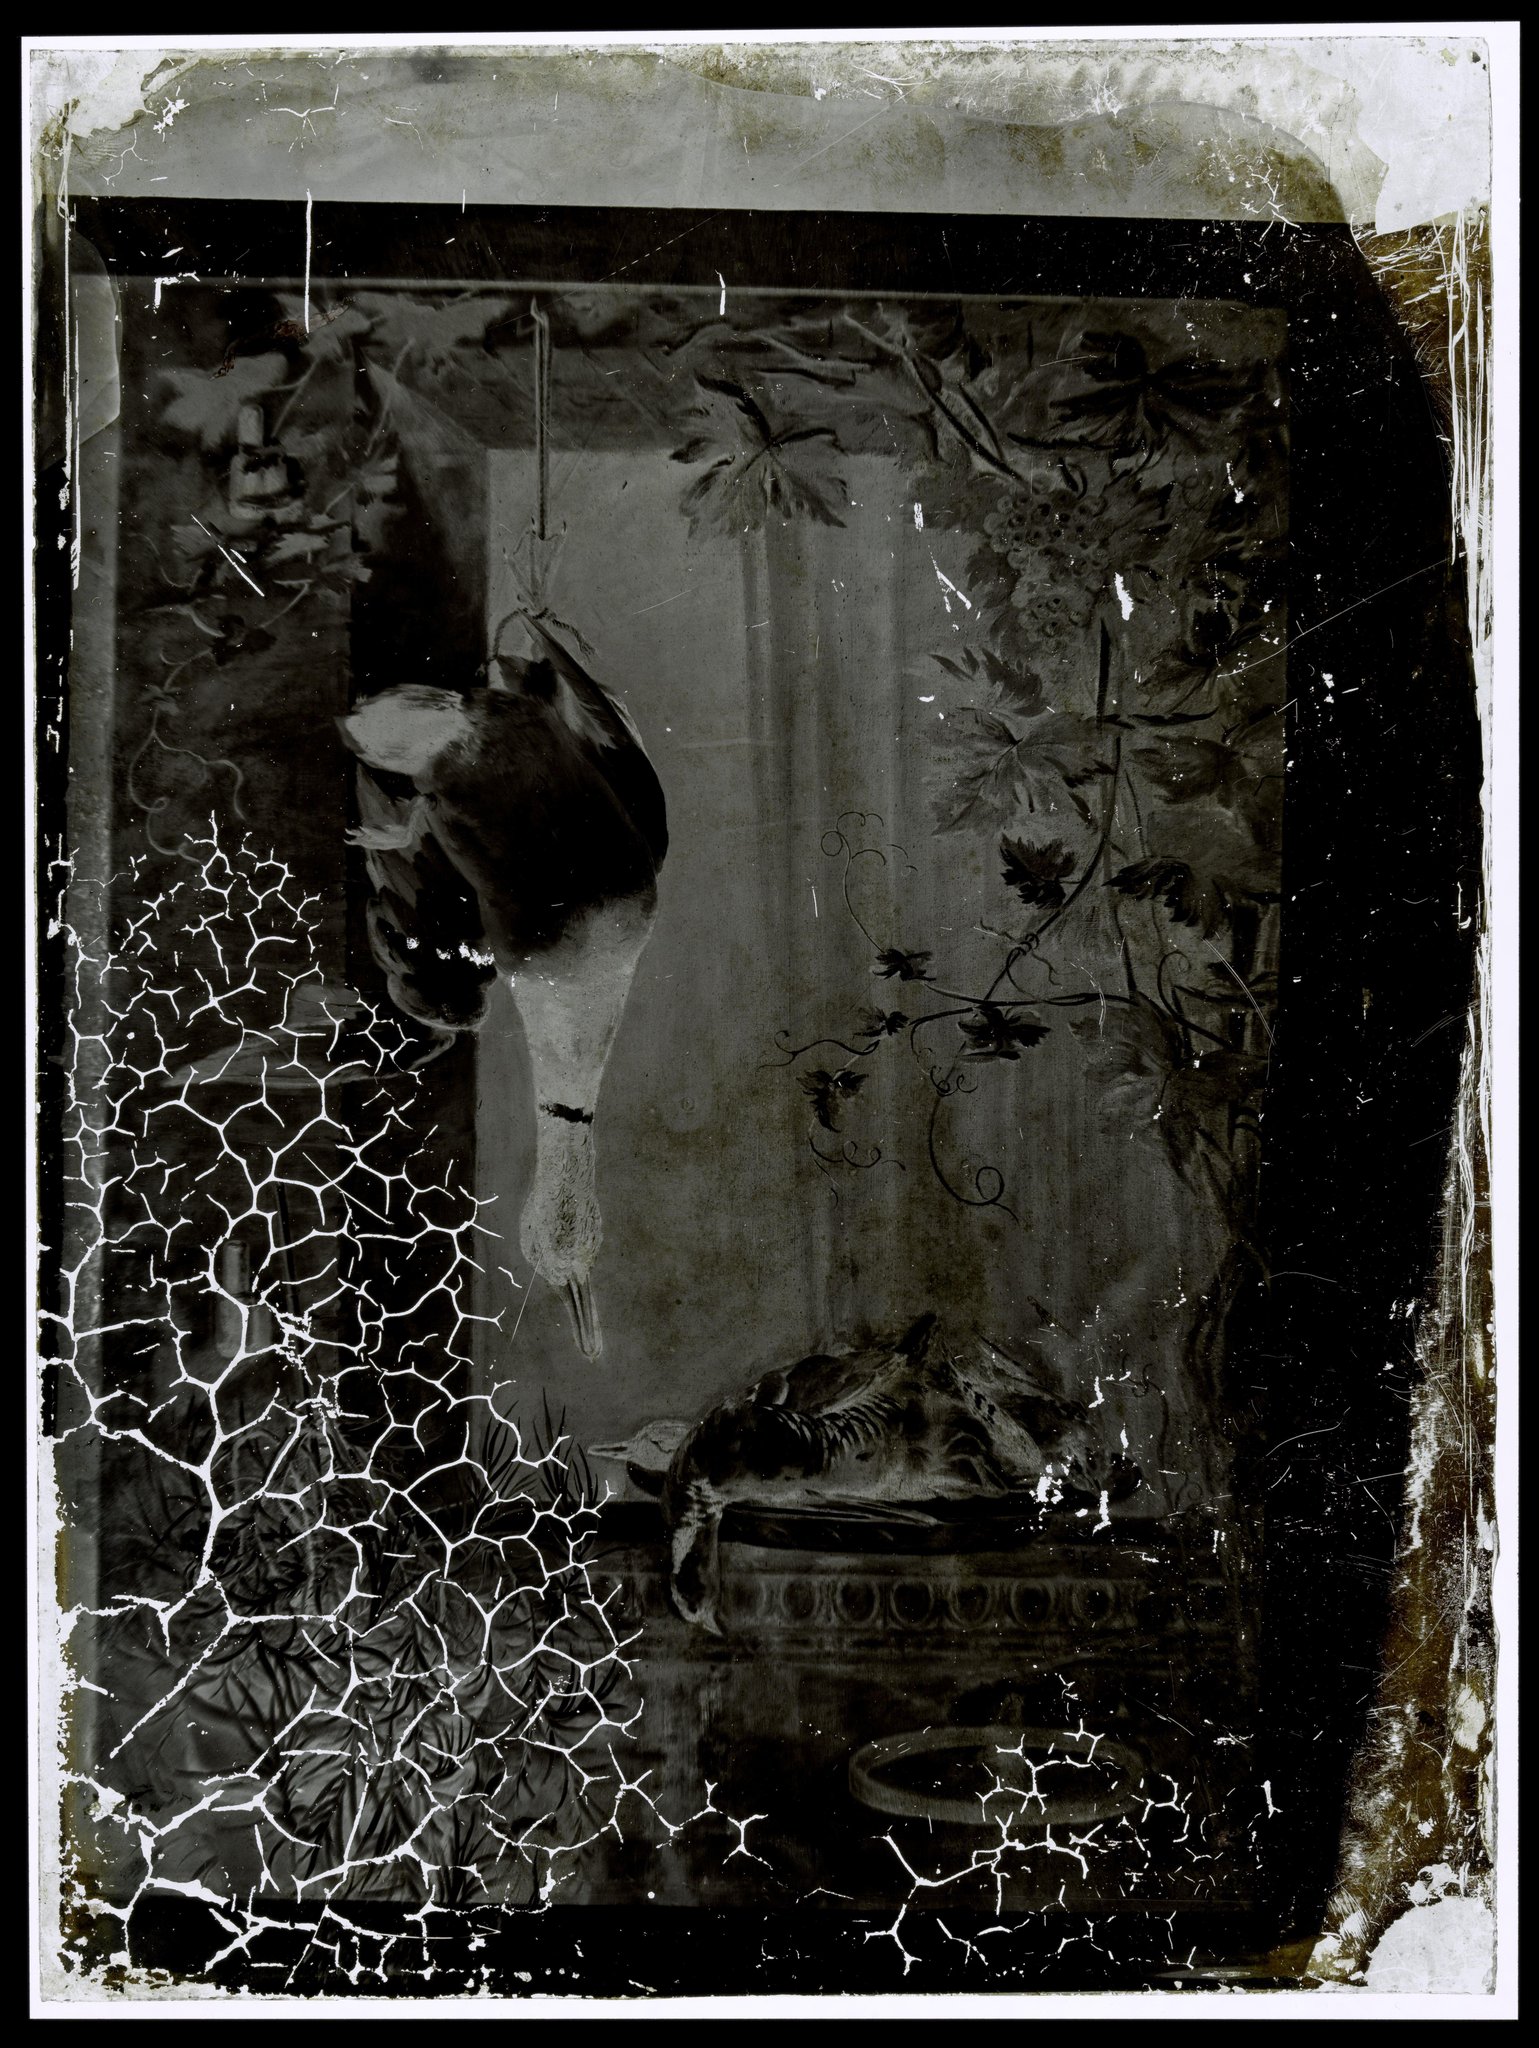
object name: glasnegatief, glasplaatnegatief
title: Intereur met hangend gevogelte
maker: laurens lodewijk kleijn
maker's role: draughtsman, painter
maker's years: 1826-1909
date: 1865-1900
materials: glass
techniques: collodion process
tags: spoils of the hunt, game, venison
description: Onderdeel van een groep glasnegatieven uit de nalatenschap van de schilder Laurens Lodewijk Kleijn, met stillevens, portretten, zelfportretten en kunstreproducties.